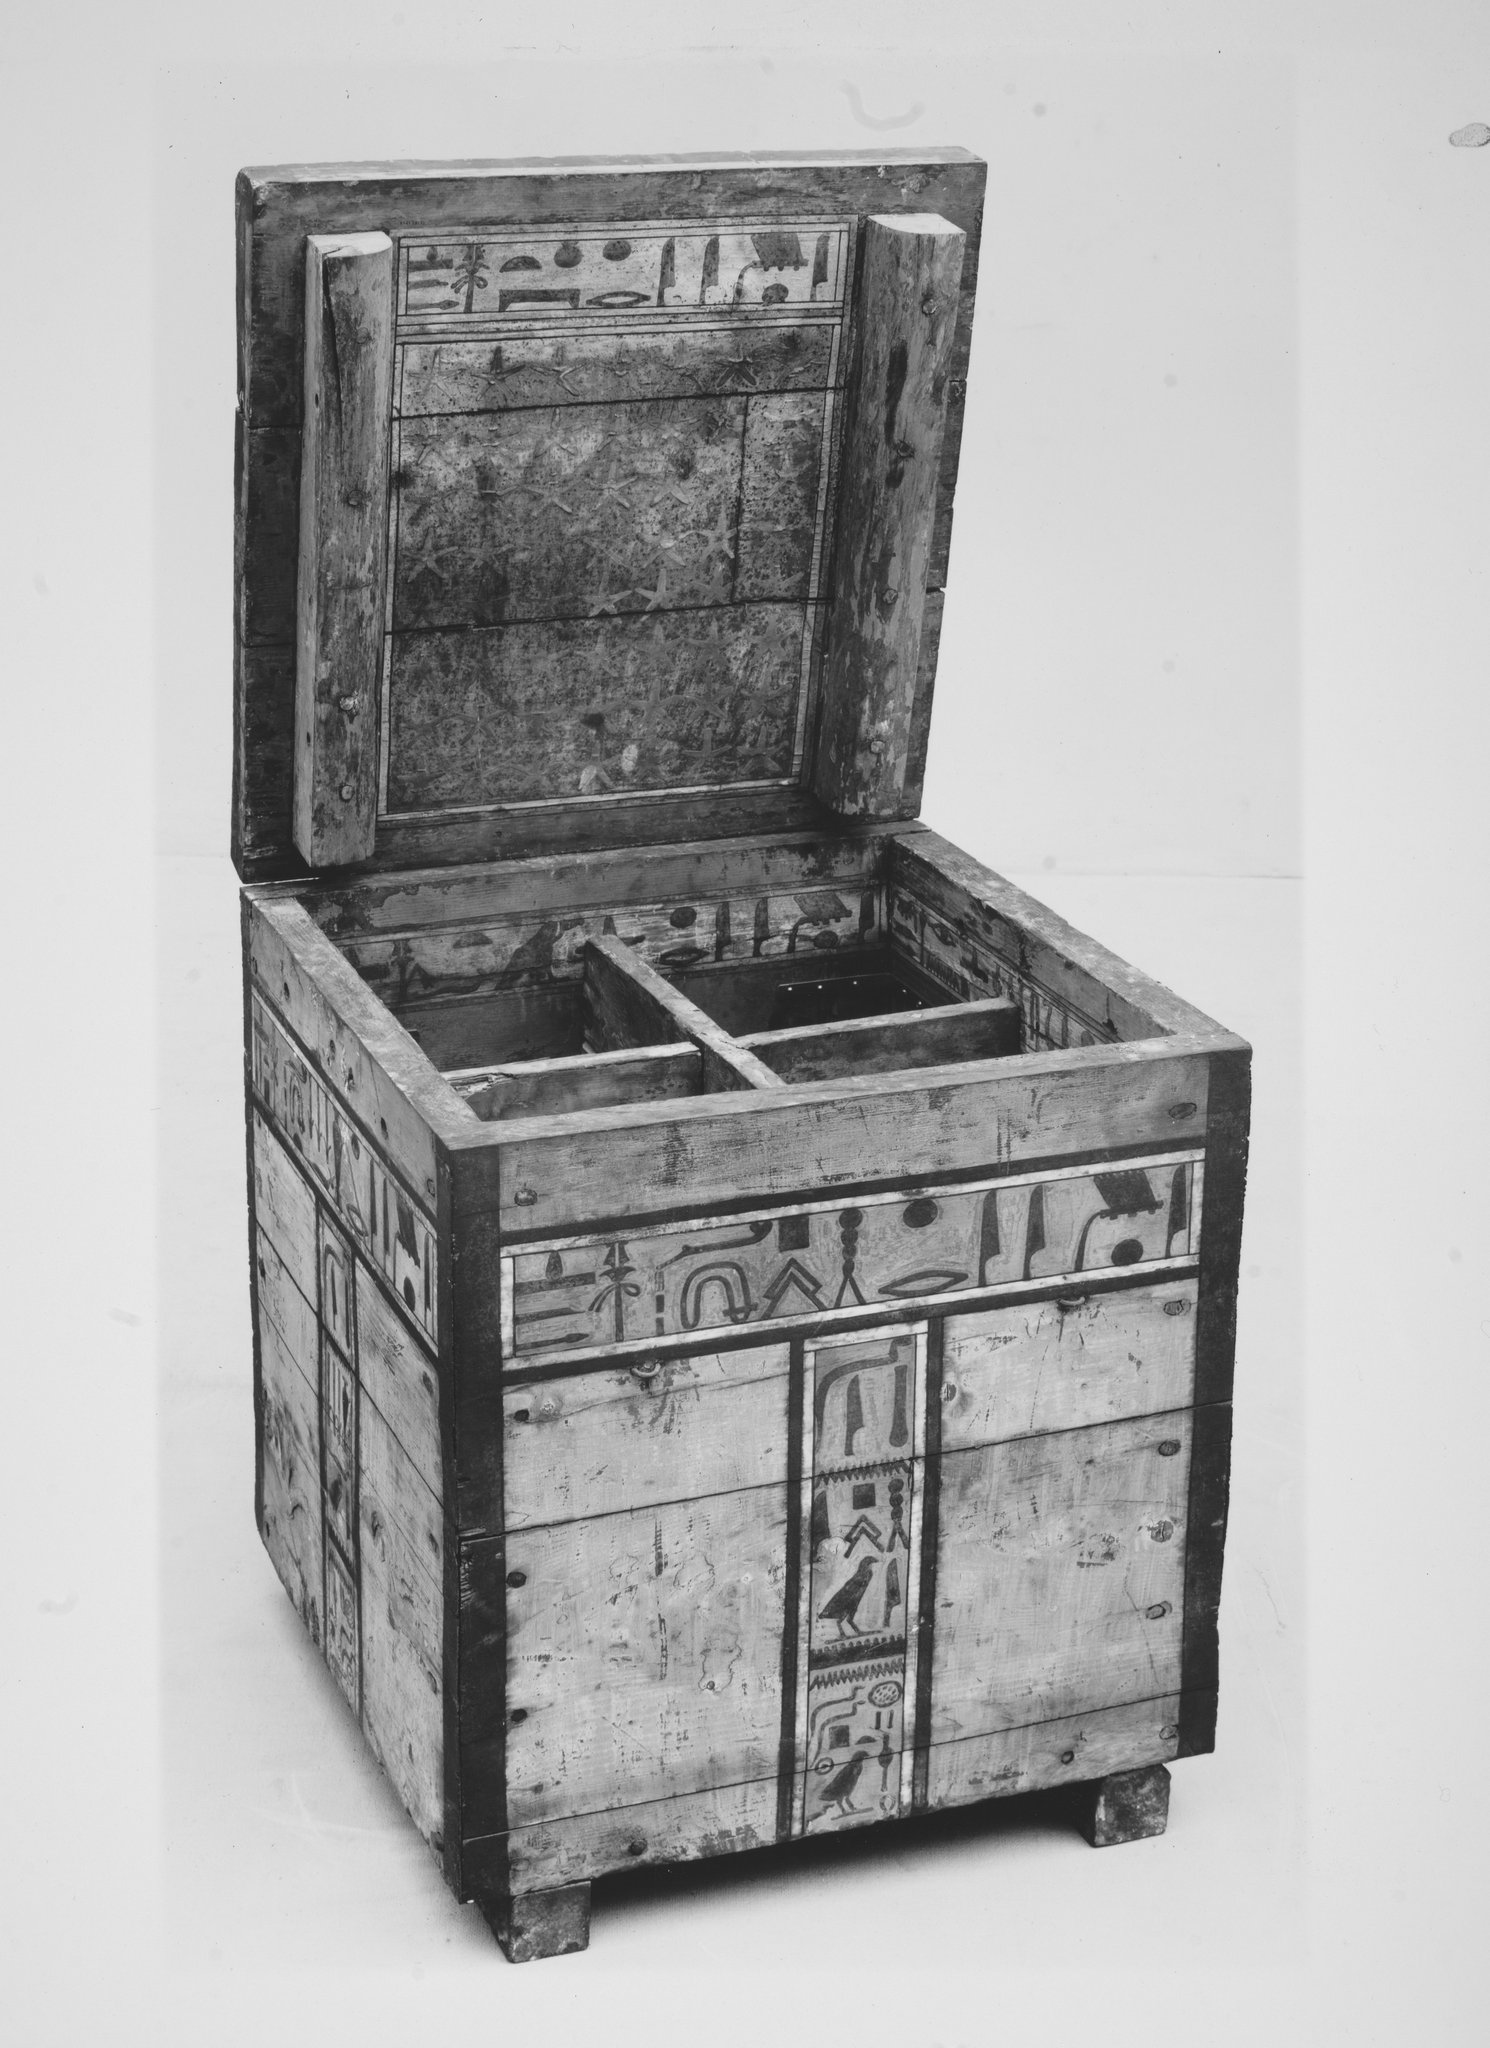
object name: canopic chest, ukhhotep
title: Canopic chest of Ukhhotep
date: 1981-1802 BCE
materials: copper, paint, wood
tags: hieroglyphs